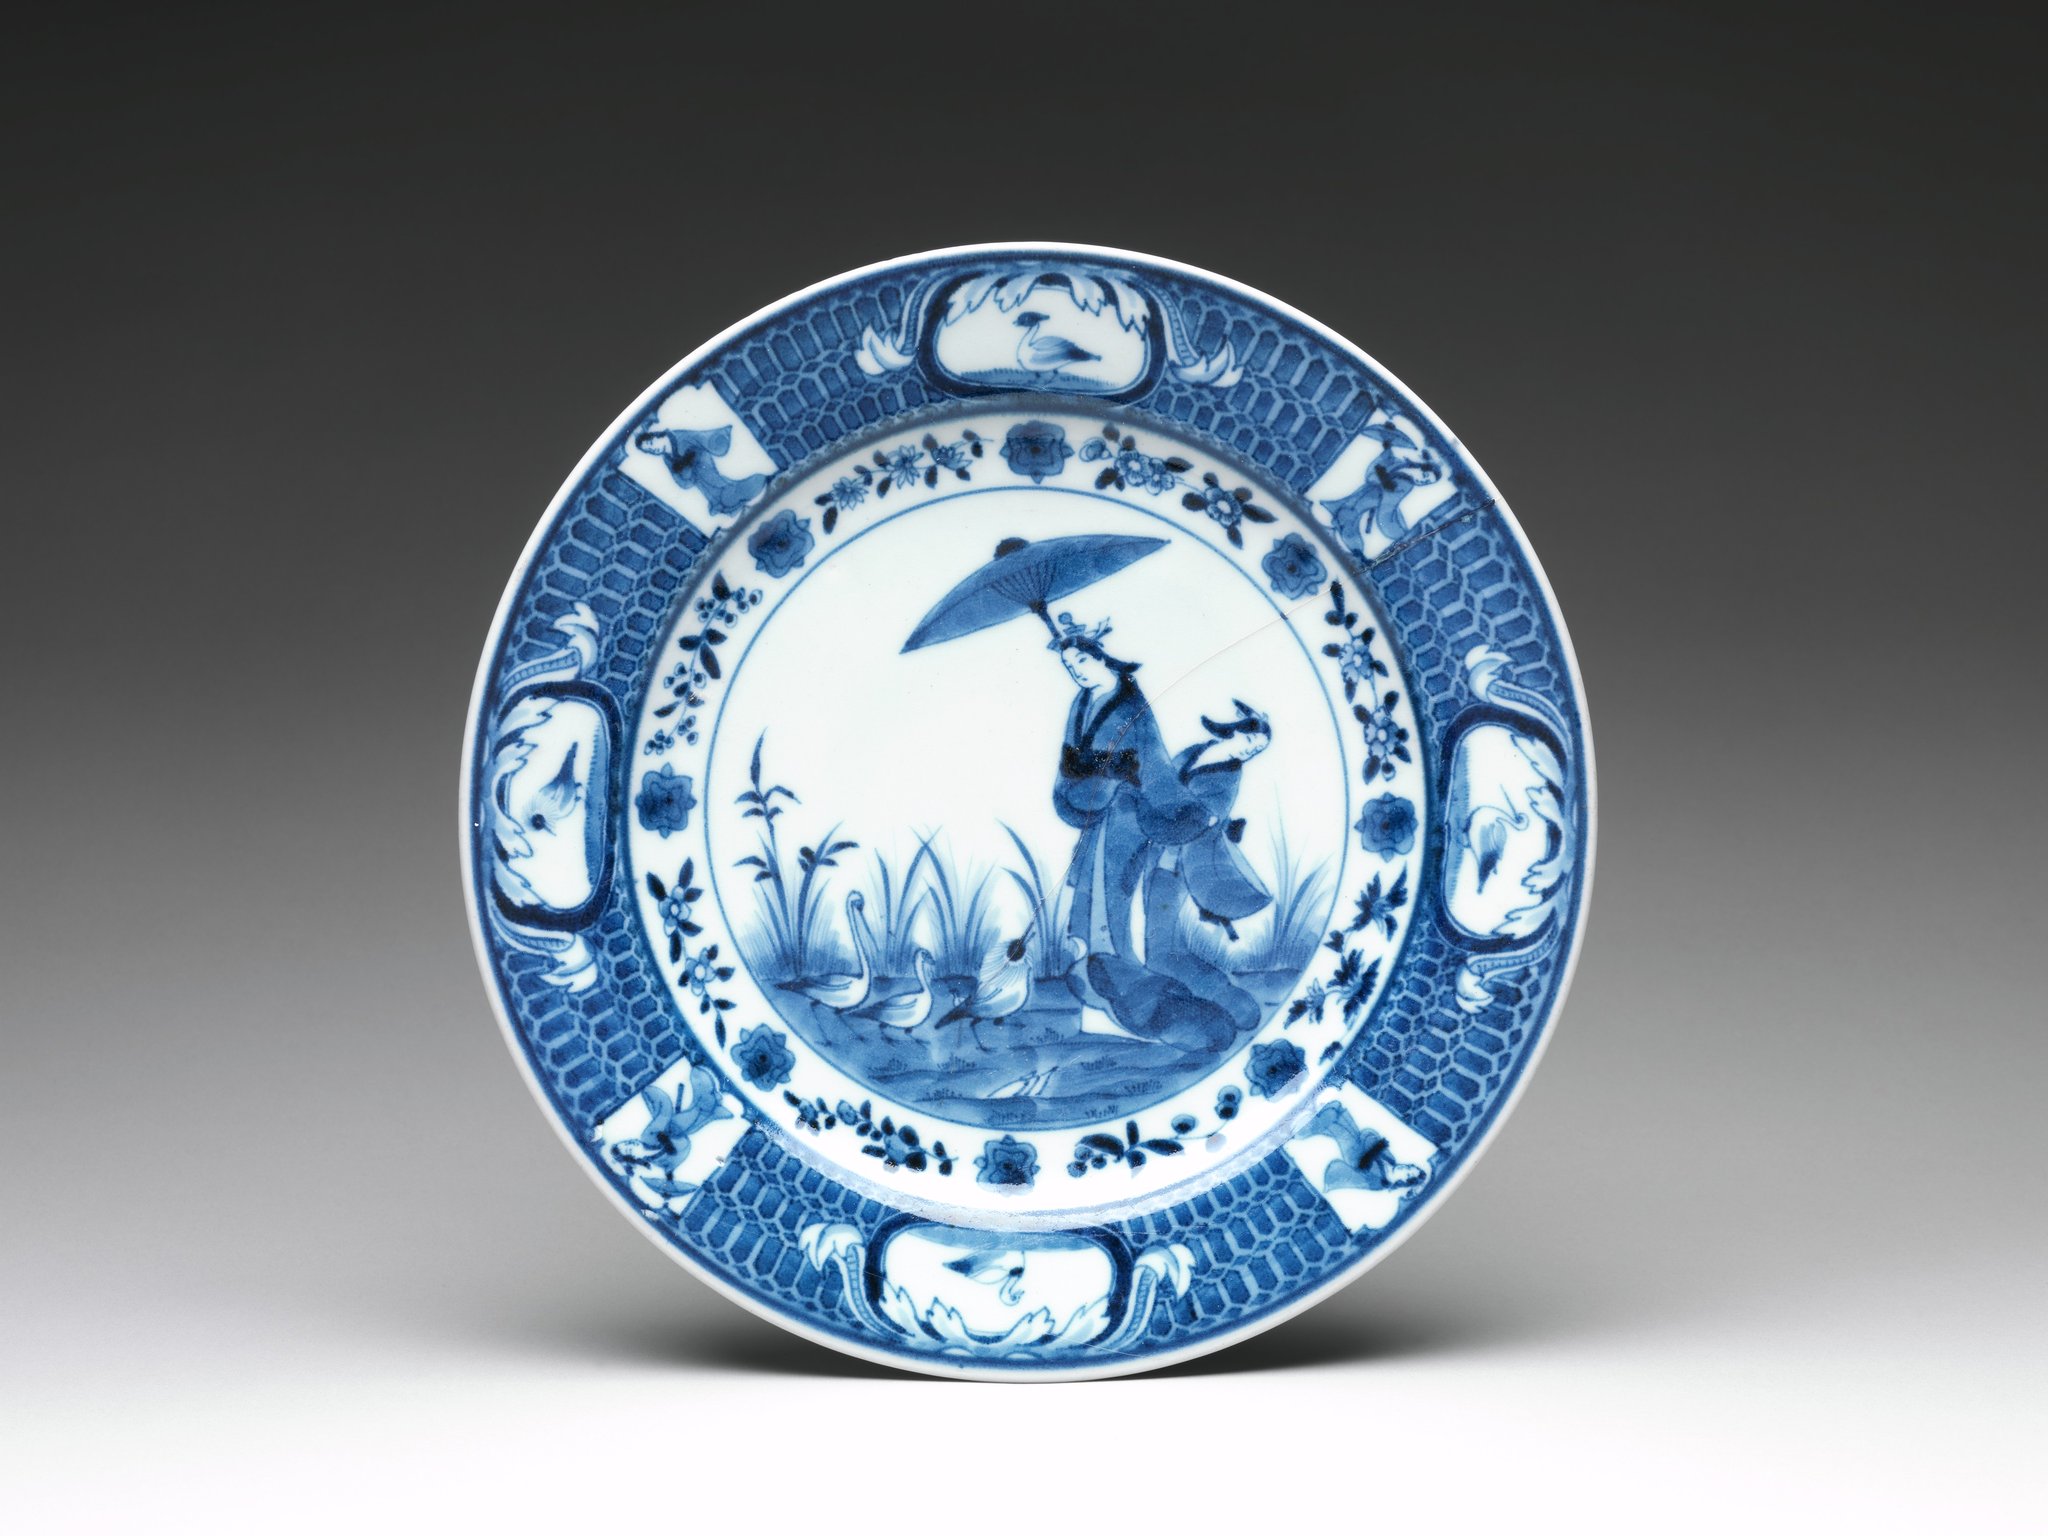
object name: dish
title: Dish with Parasol Ladies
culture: japanese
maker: cornelis pronk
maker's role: artist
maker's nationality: dutch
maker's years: 1691-1759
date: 1735-1740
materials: cobalt, enamel, glaze, porcelain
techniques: painting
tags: birds,women,parasols